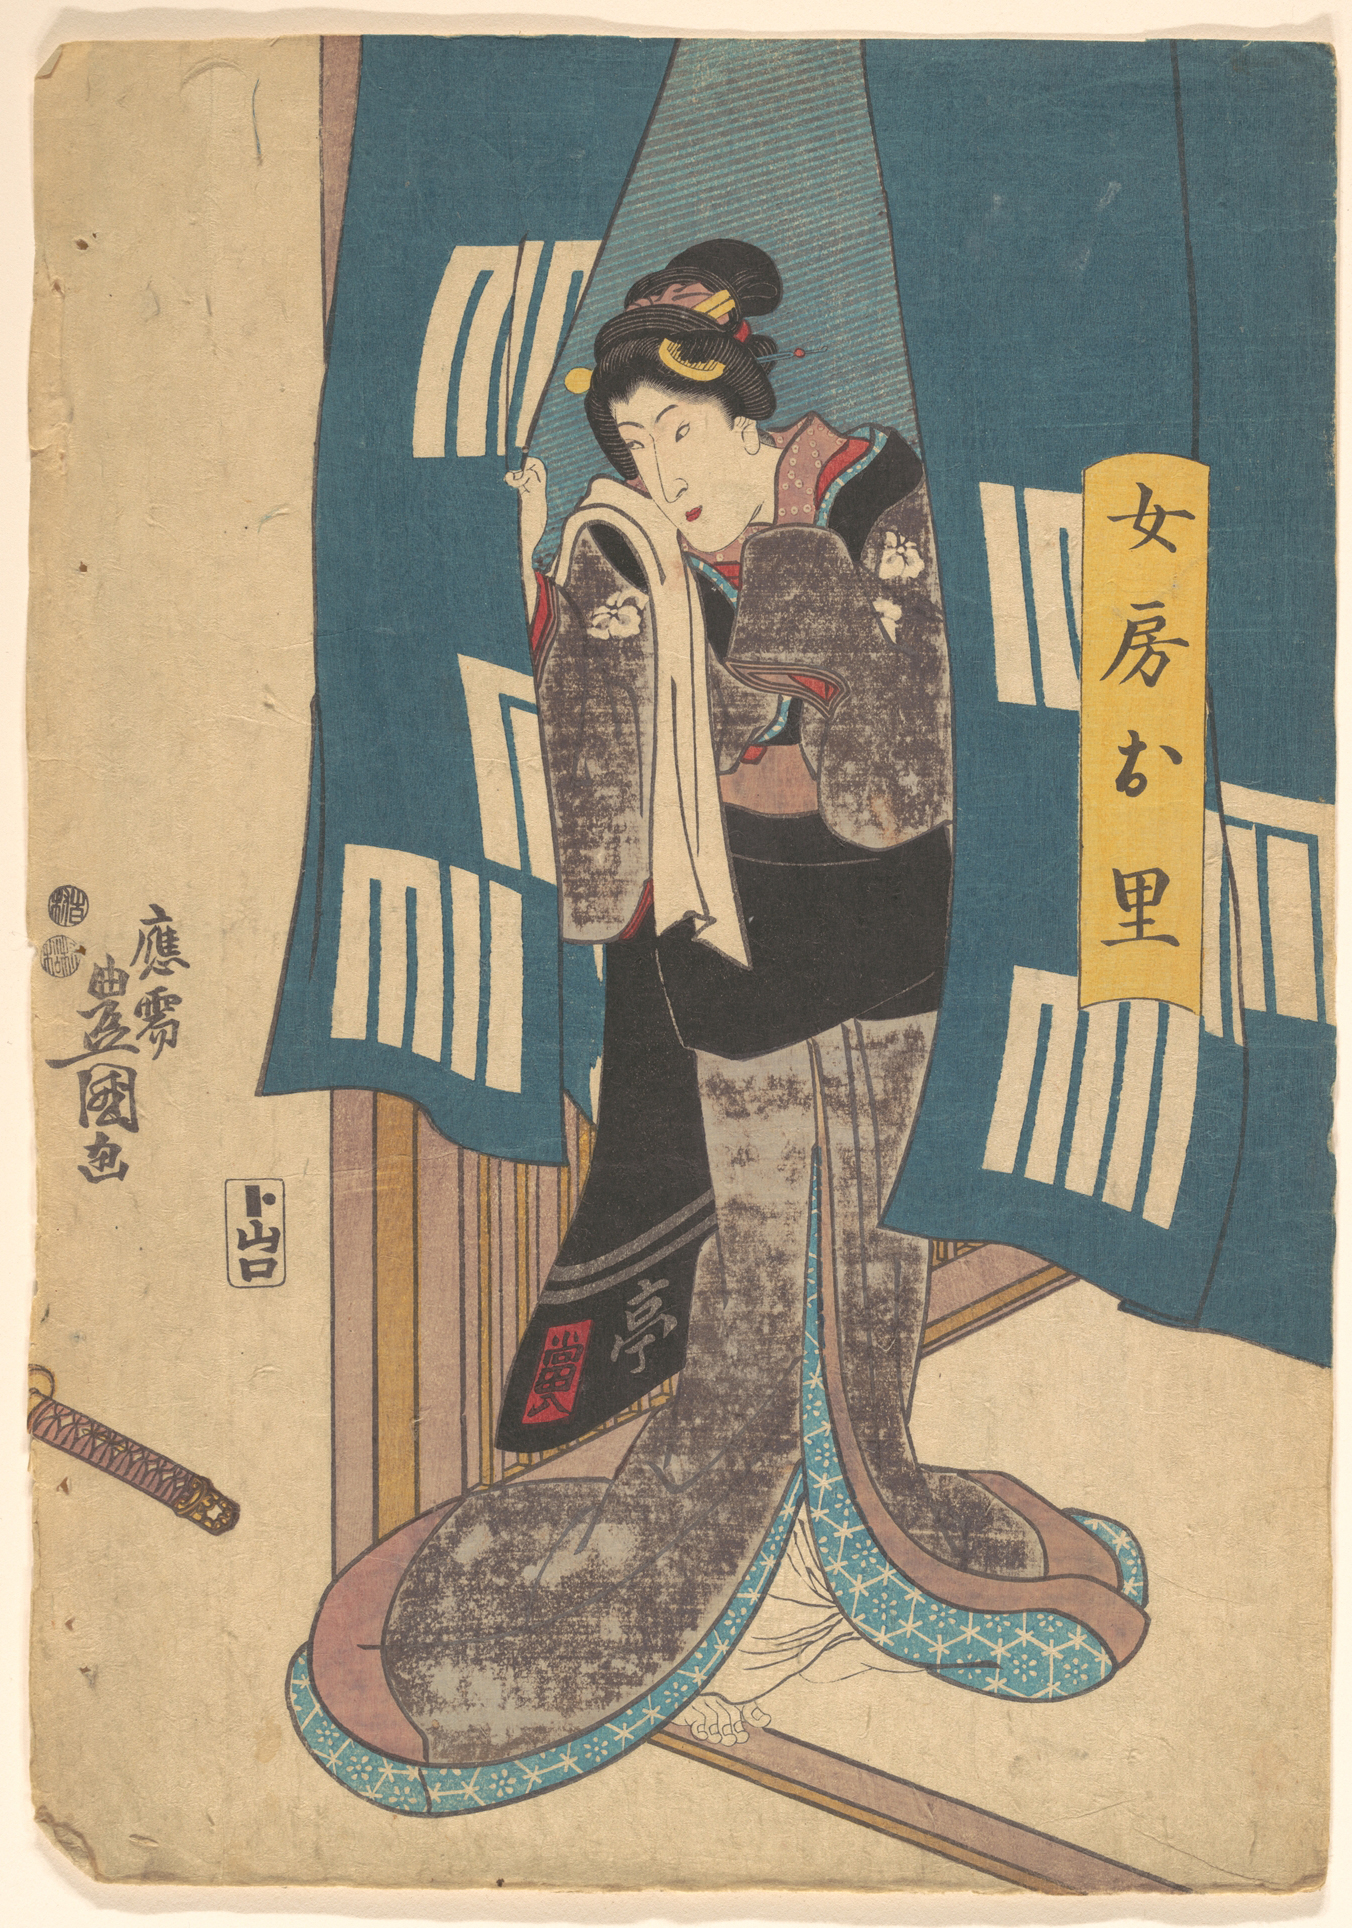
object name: print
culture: japanese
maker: utagawa kunisada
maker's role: artist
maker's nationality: japanese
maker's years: 1786-1864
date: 1801-1900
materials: ink, paper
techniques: woodblock print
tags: women